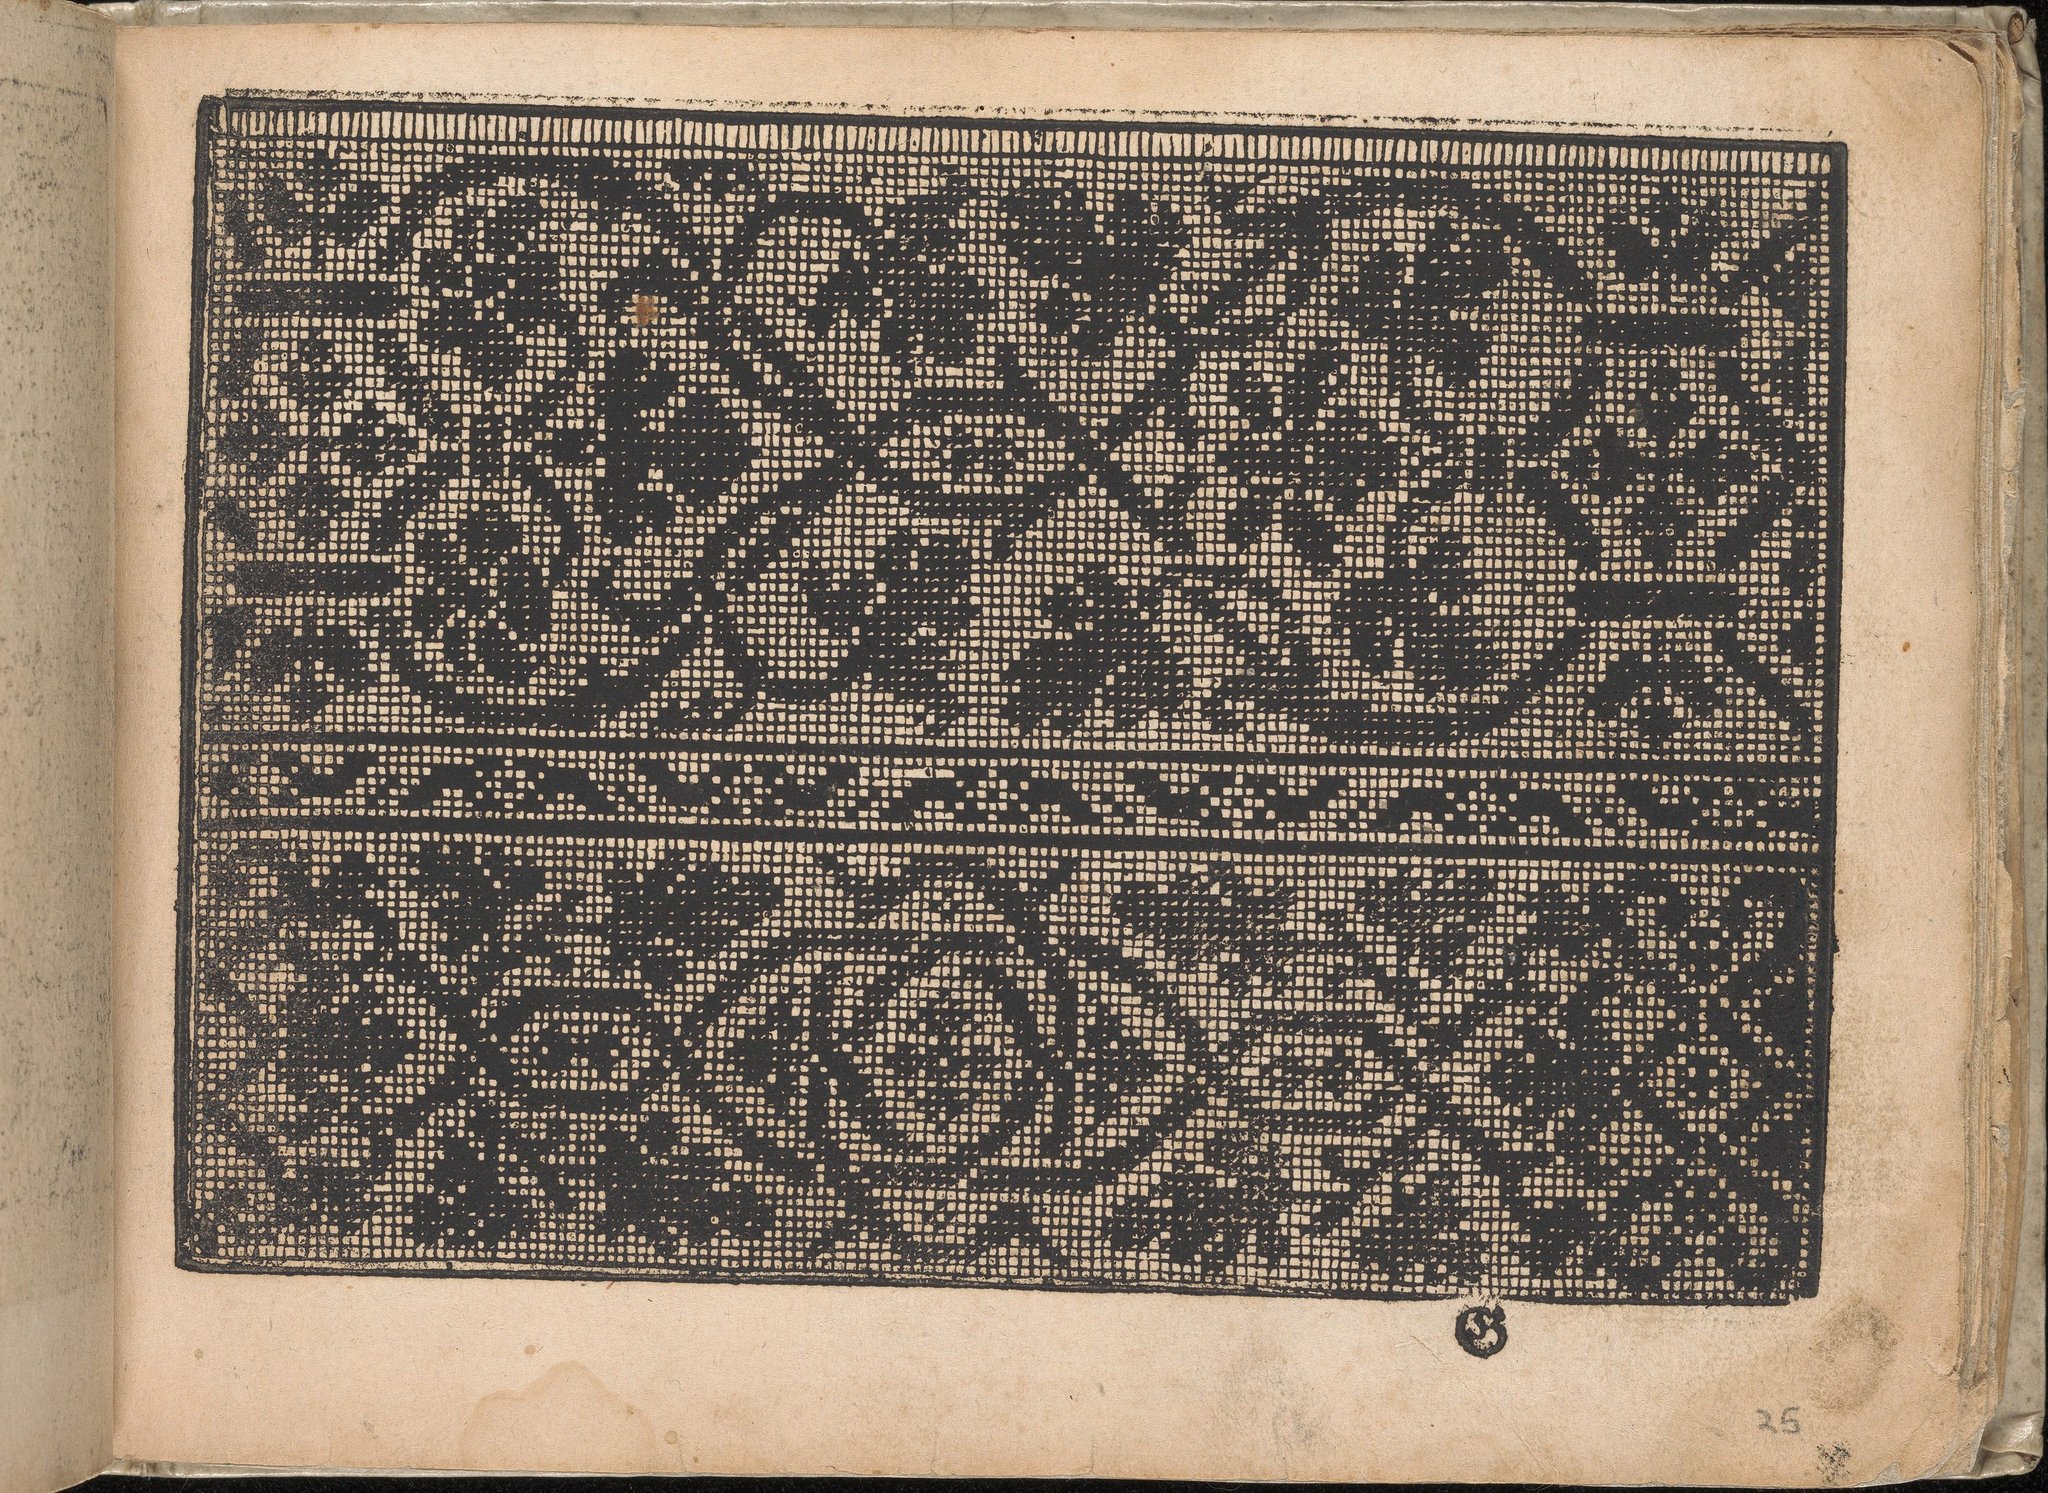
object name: book print ornament architecture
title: Neu künstlich Modelbuch (page 25r)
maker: bernhard jobin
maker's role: publisher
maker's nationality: swiss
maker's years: 1535-1597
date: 1598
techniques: woodcut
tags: flowers